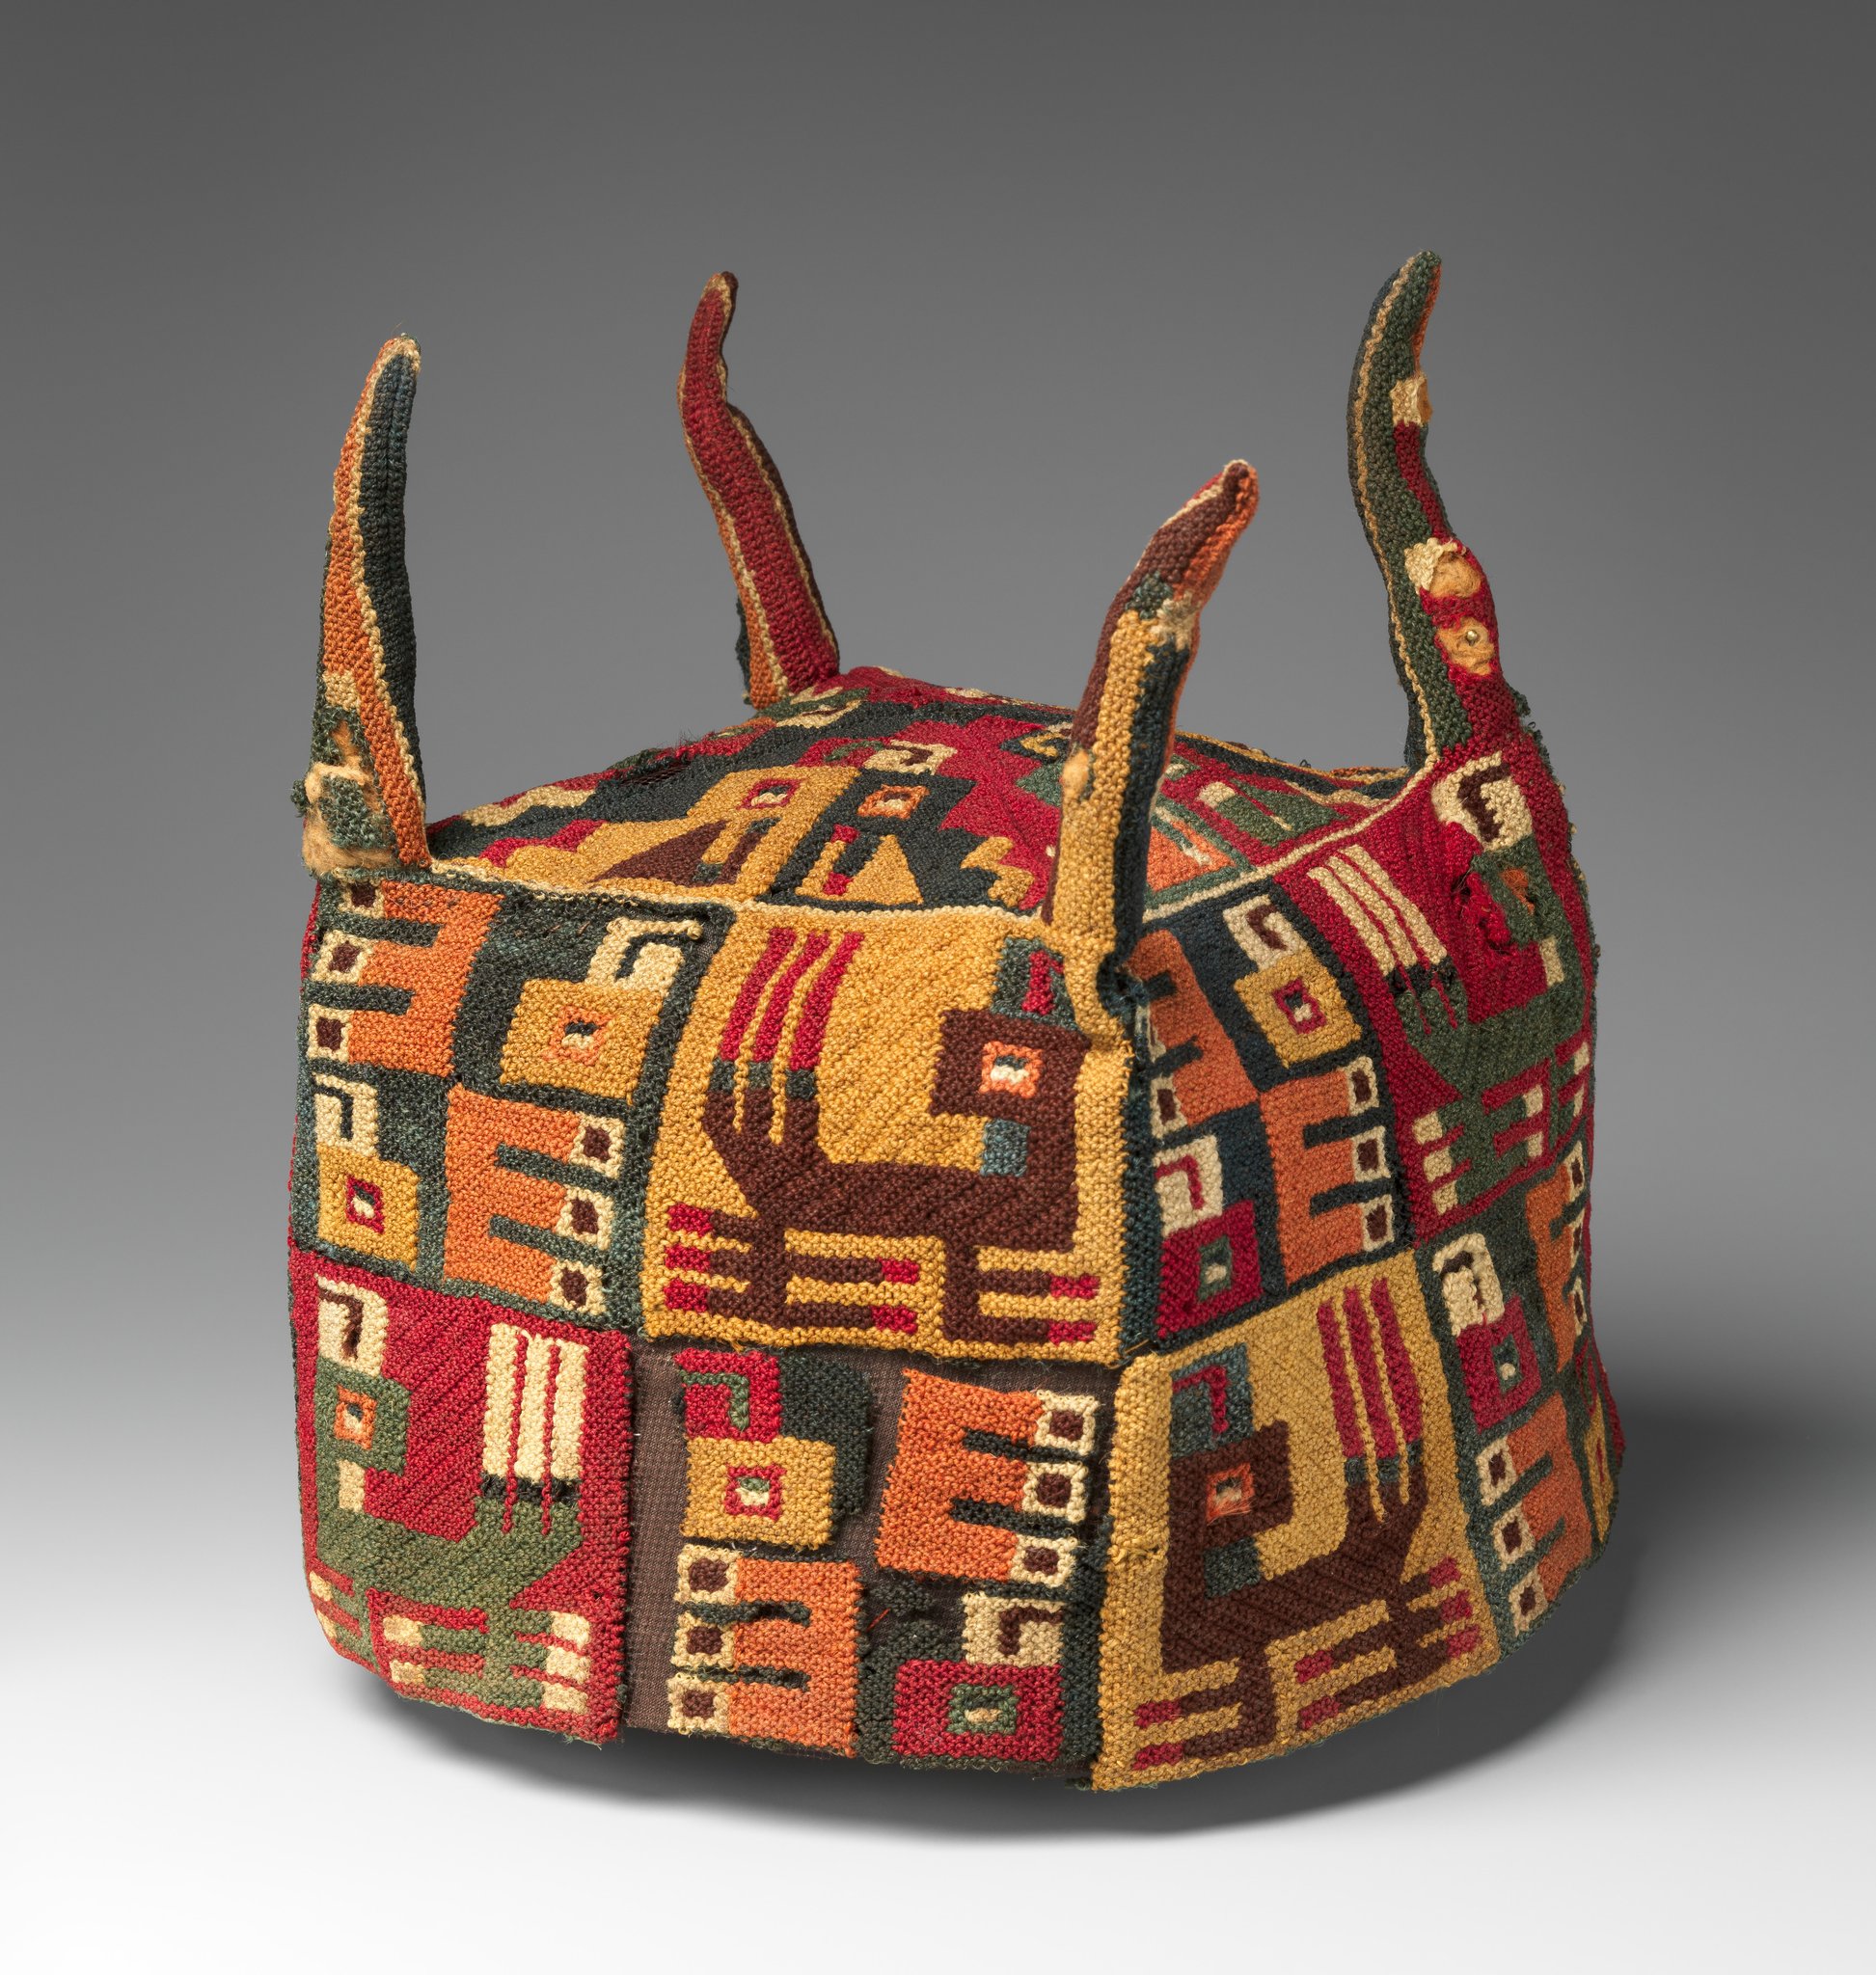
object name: hat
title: Four-Cornered Hat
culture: tiwanaku or wari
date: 500-900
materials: animal fiber, fiber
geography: bolivia